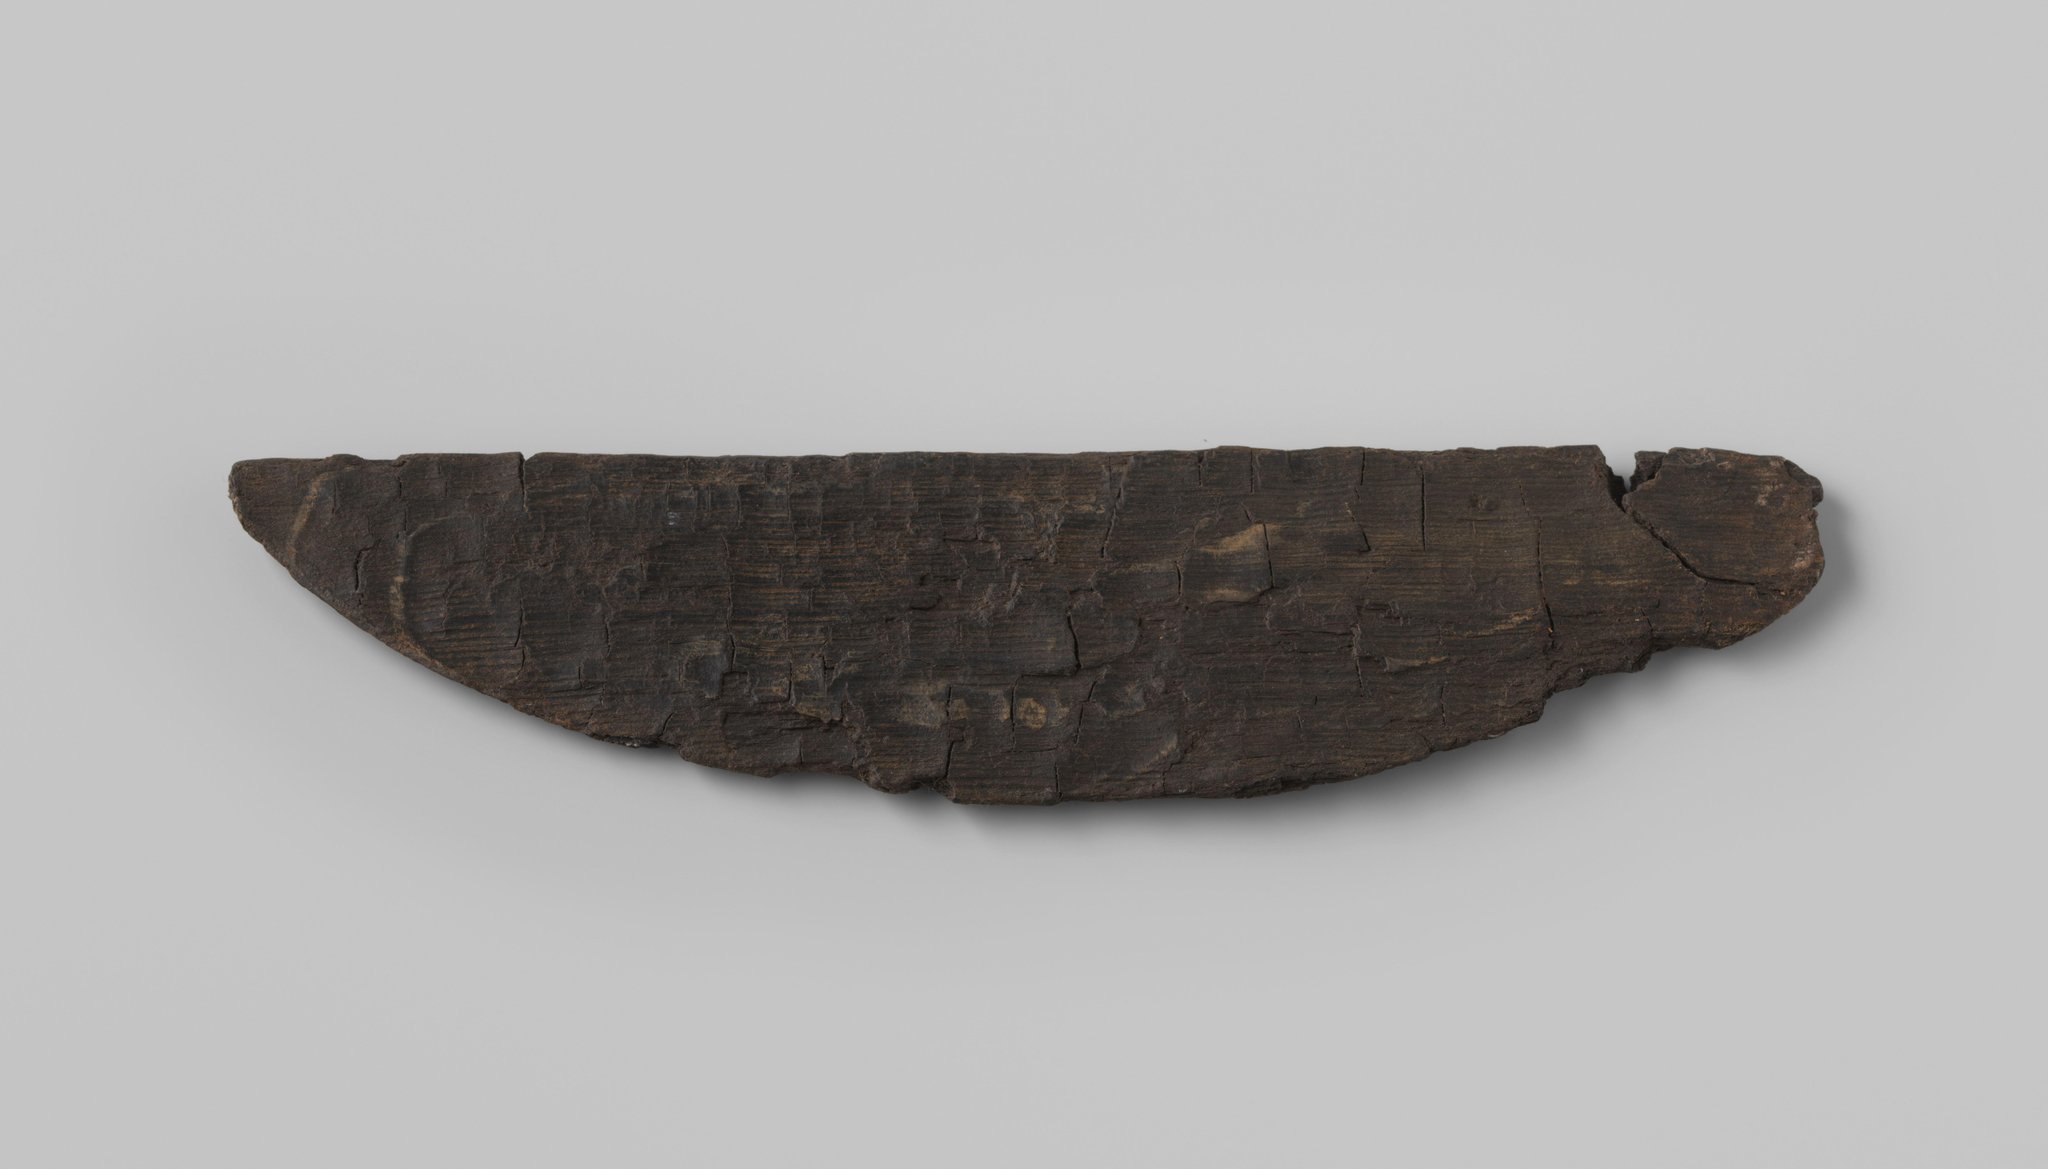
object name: vessel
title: Fragment deksel van een vat uit het wrak van de Oost-Indiëvaarder Hollandia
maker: Anonymous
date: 1700-1743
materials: wood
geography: netherlands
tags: verenigde oostindische compagnie, hollandia (schip), annet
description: Barrel, lid; fragm, eroded, oblong semicircular outline with bevelled edge, one straight side.